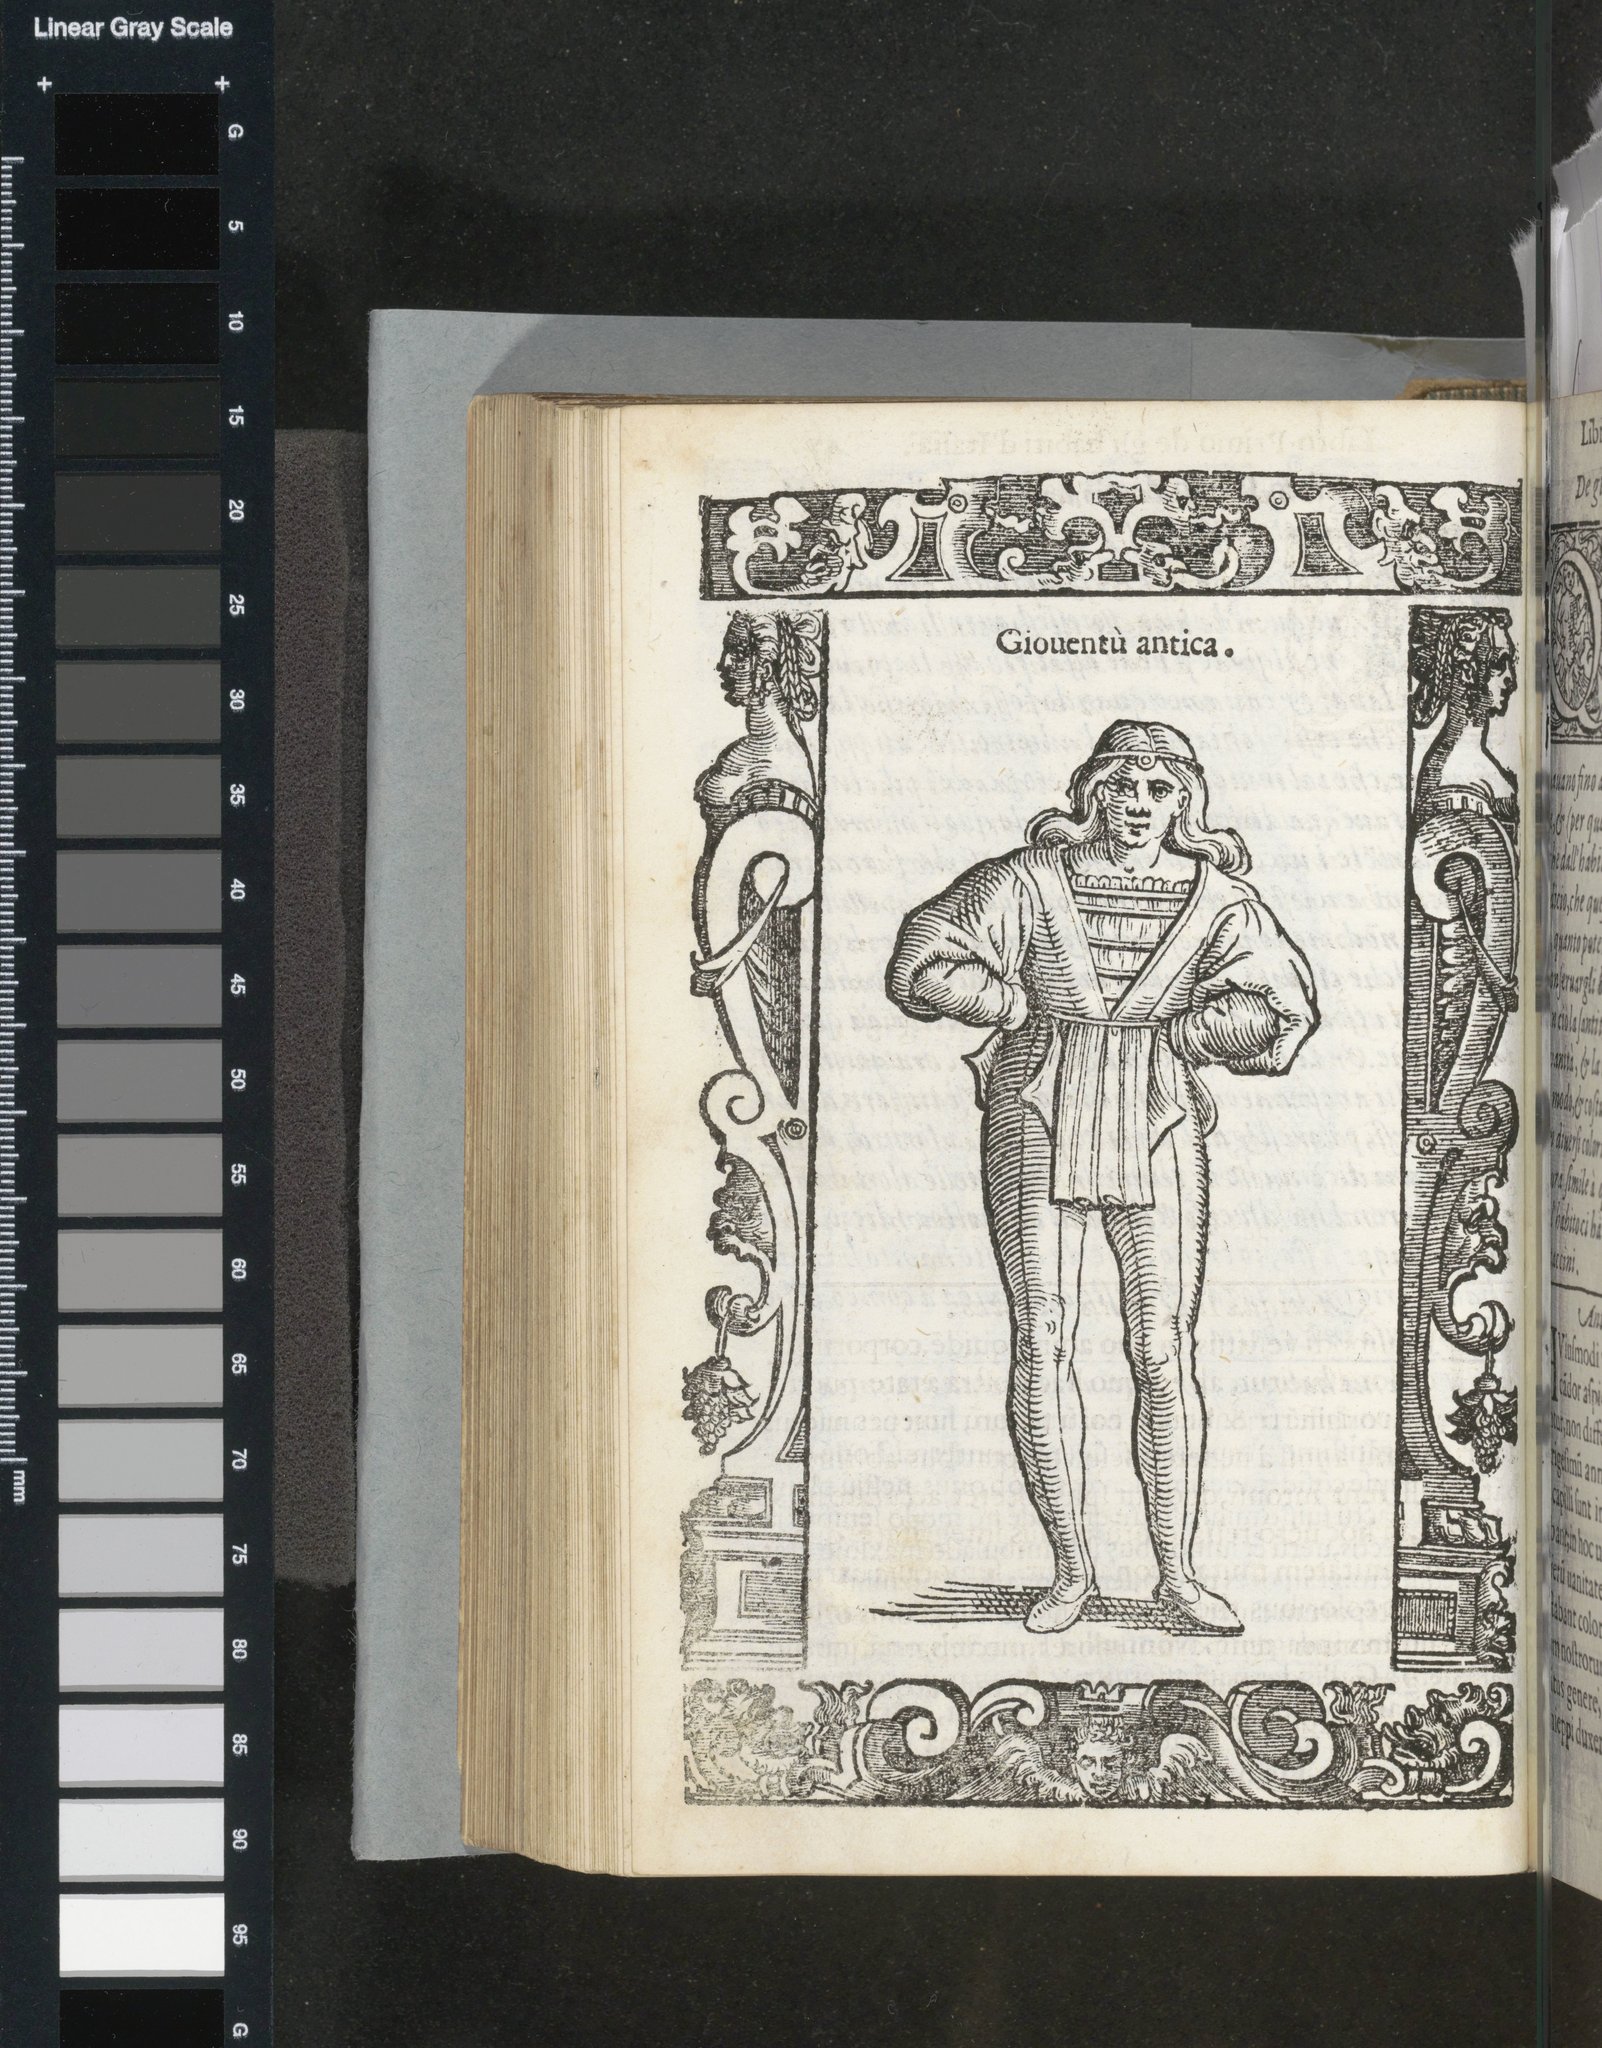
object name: costume print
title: Gioventu antica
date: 1598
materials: paper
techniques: woodcut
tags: fashion plates